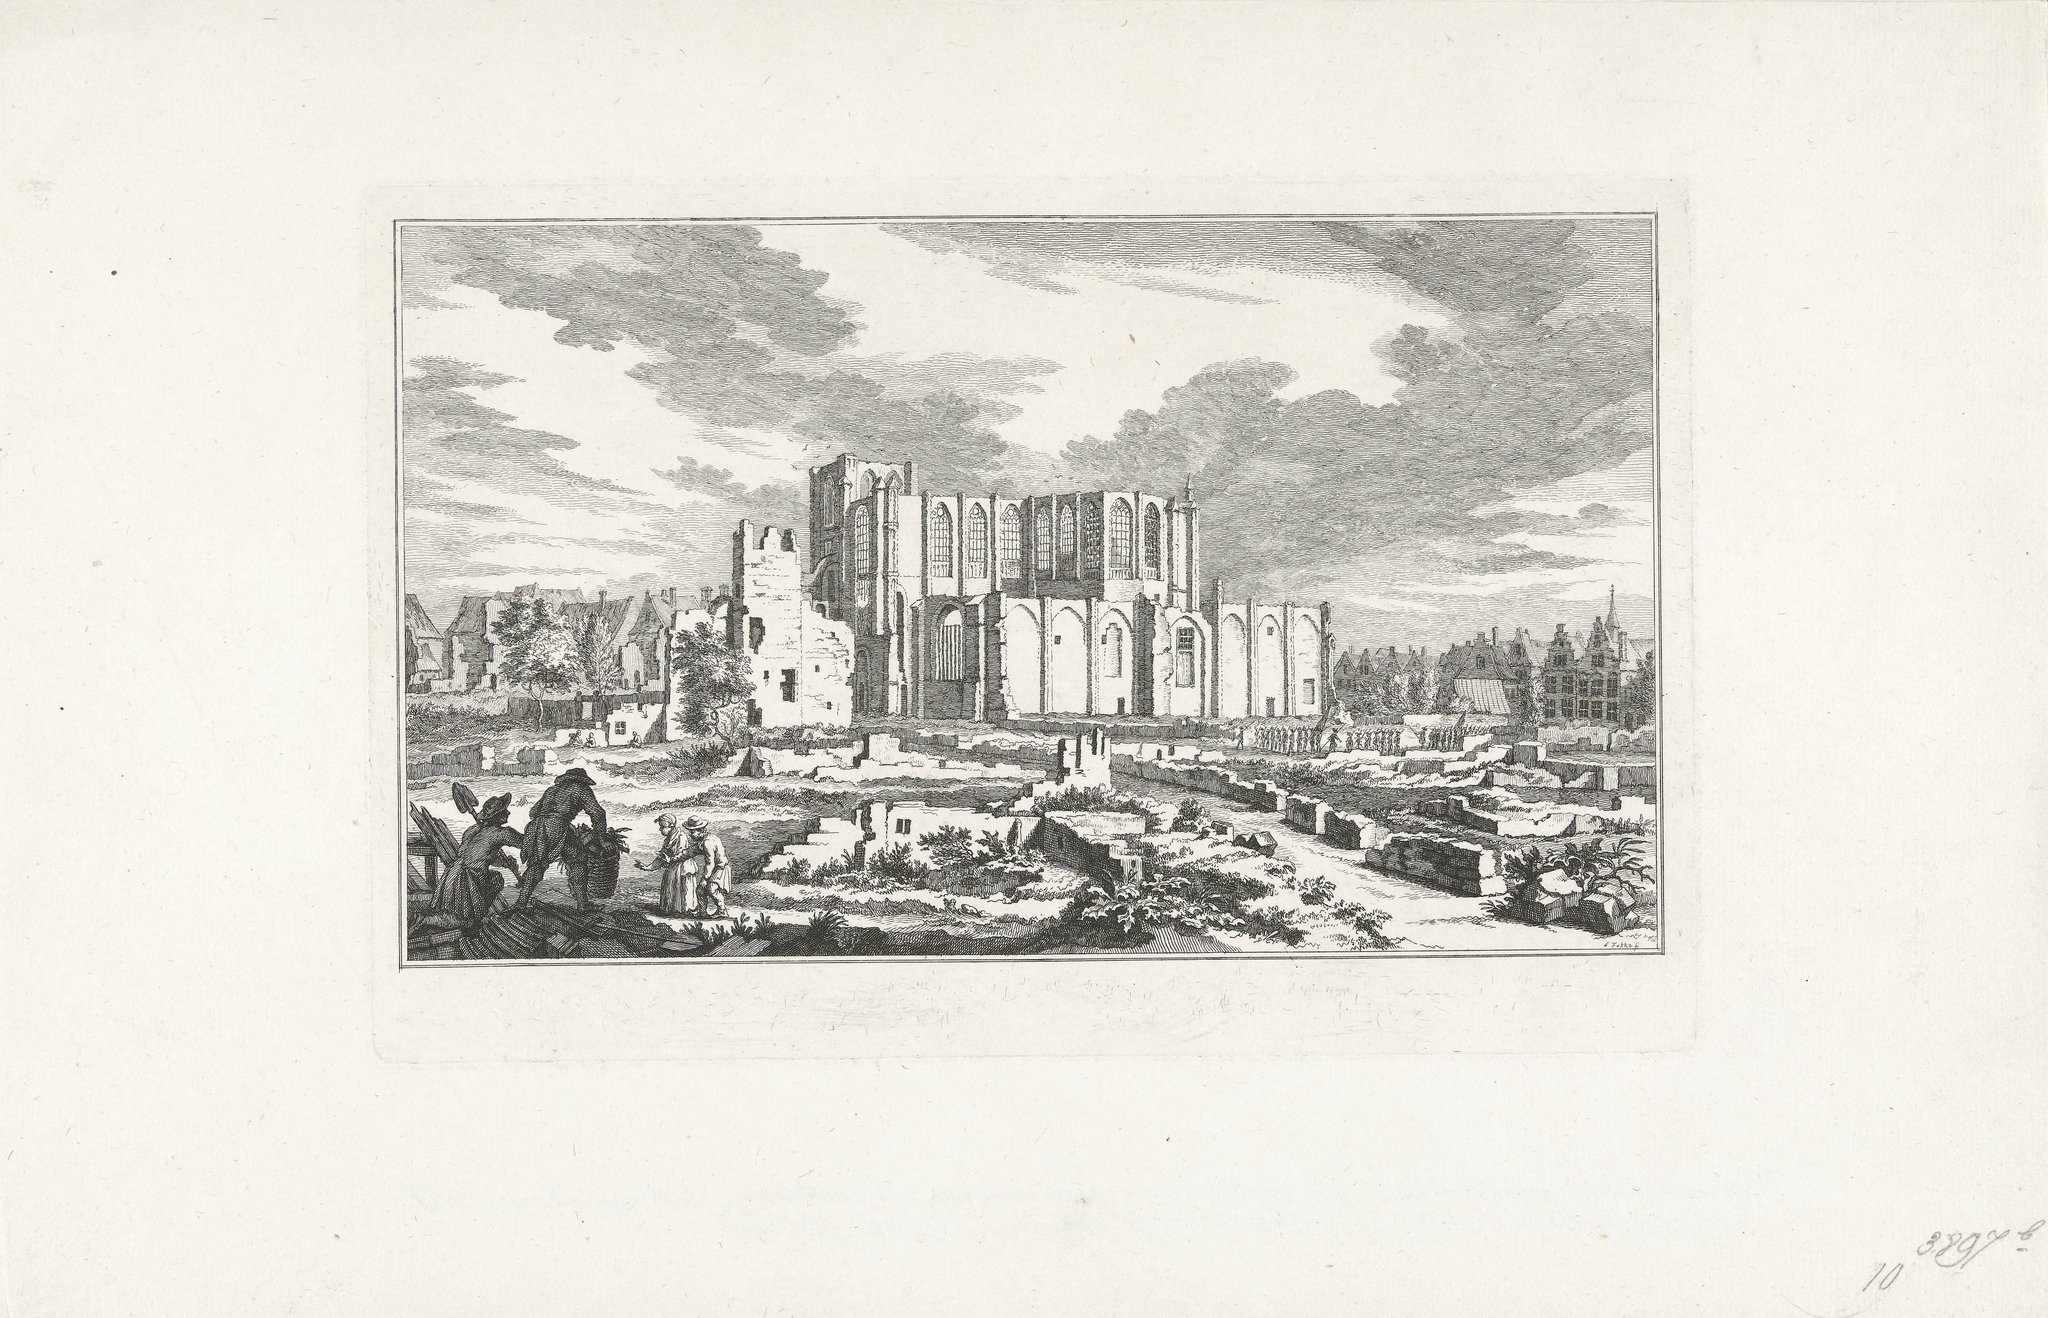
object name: book illustration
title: Ruïne van de Grote Kerk van Bergen op Zoom, 1748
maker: simon fokke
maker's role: draughtsman, print maker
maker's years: 1712-1784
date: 1772-1780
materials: paper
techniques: etching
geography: northern netherlands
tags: ruin of church, monastery, etc., devastated, ruined place or city (~ warfare), bergen op zoom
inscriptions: collector's mark: Lugt 2228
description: Prent ook gebruikt in: Beschryving der stad Bergen op den Zoom (…). 1e druk. Amsterdam: Arend Fokke Simonsz., 1780. Muller geeft aan dat de prenten door Simon Fokke in 1772 naar de tekeningen van Pronk uit 1748 zijn vervaardigd. In de Collecties Thuis in Brabant (collecties in Brabantse musea en archieven) is een ontwerptekening (met inv.nr.: BC-Tha oai:tha.uvt.nl:709121) voor deze prent in de serie bewaard met de annotatie: Hoogstraat. na t Leven geschest (sic) door C.Pronk 1748. opgetekent door S. Fokke 1772.